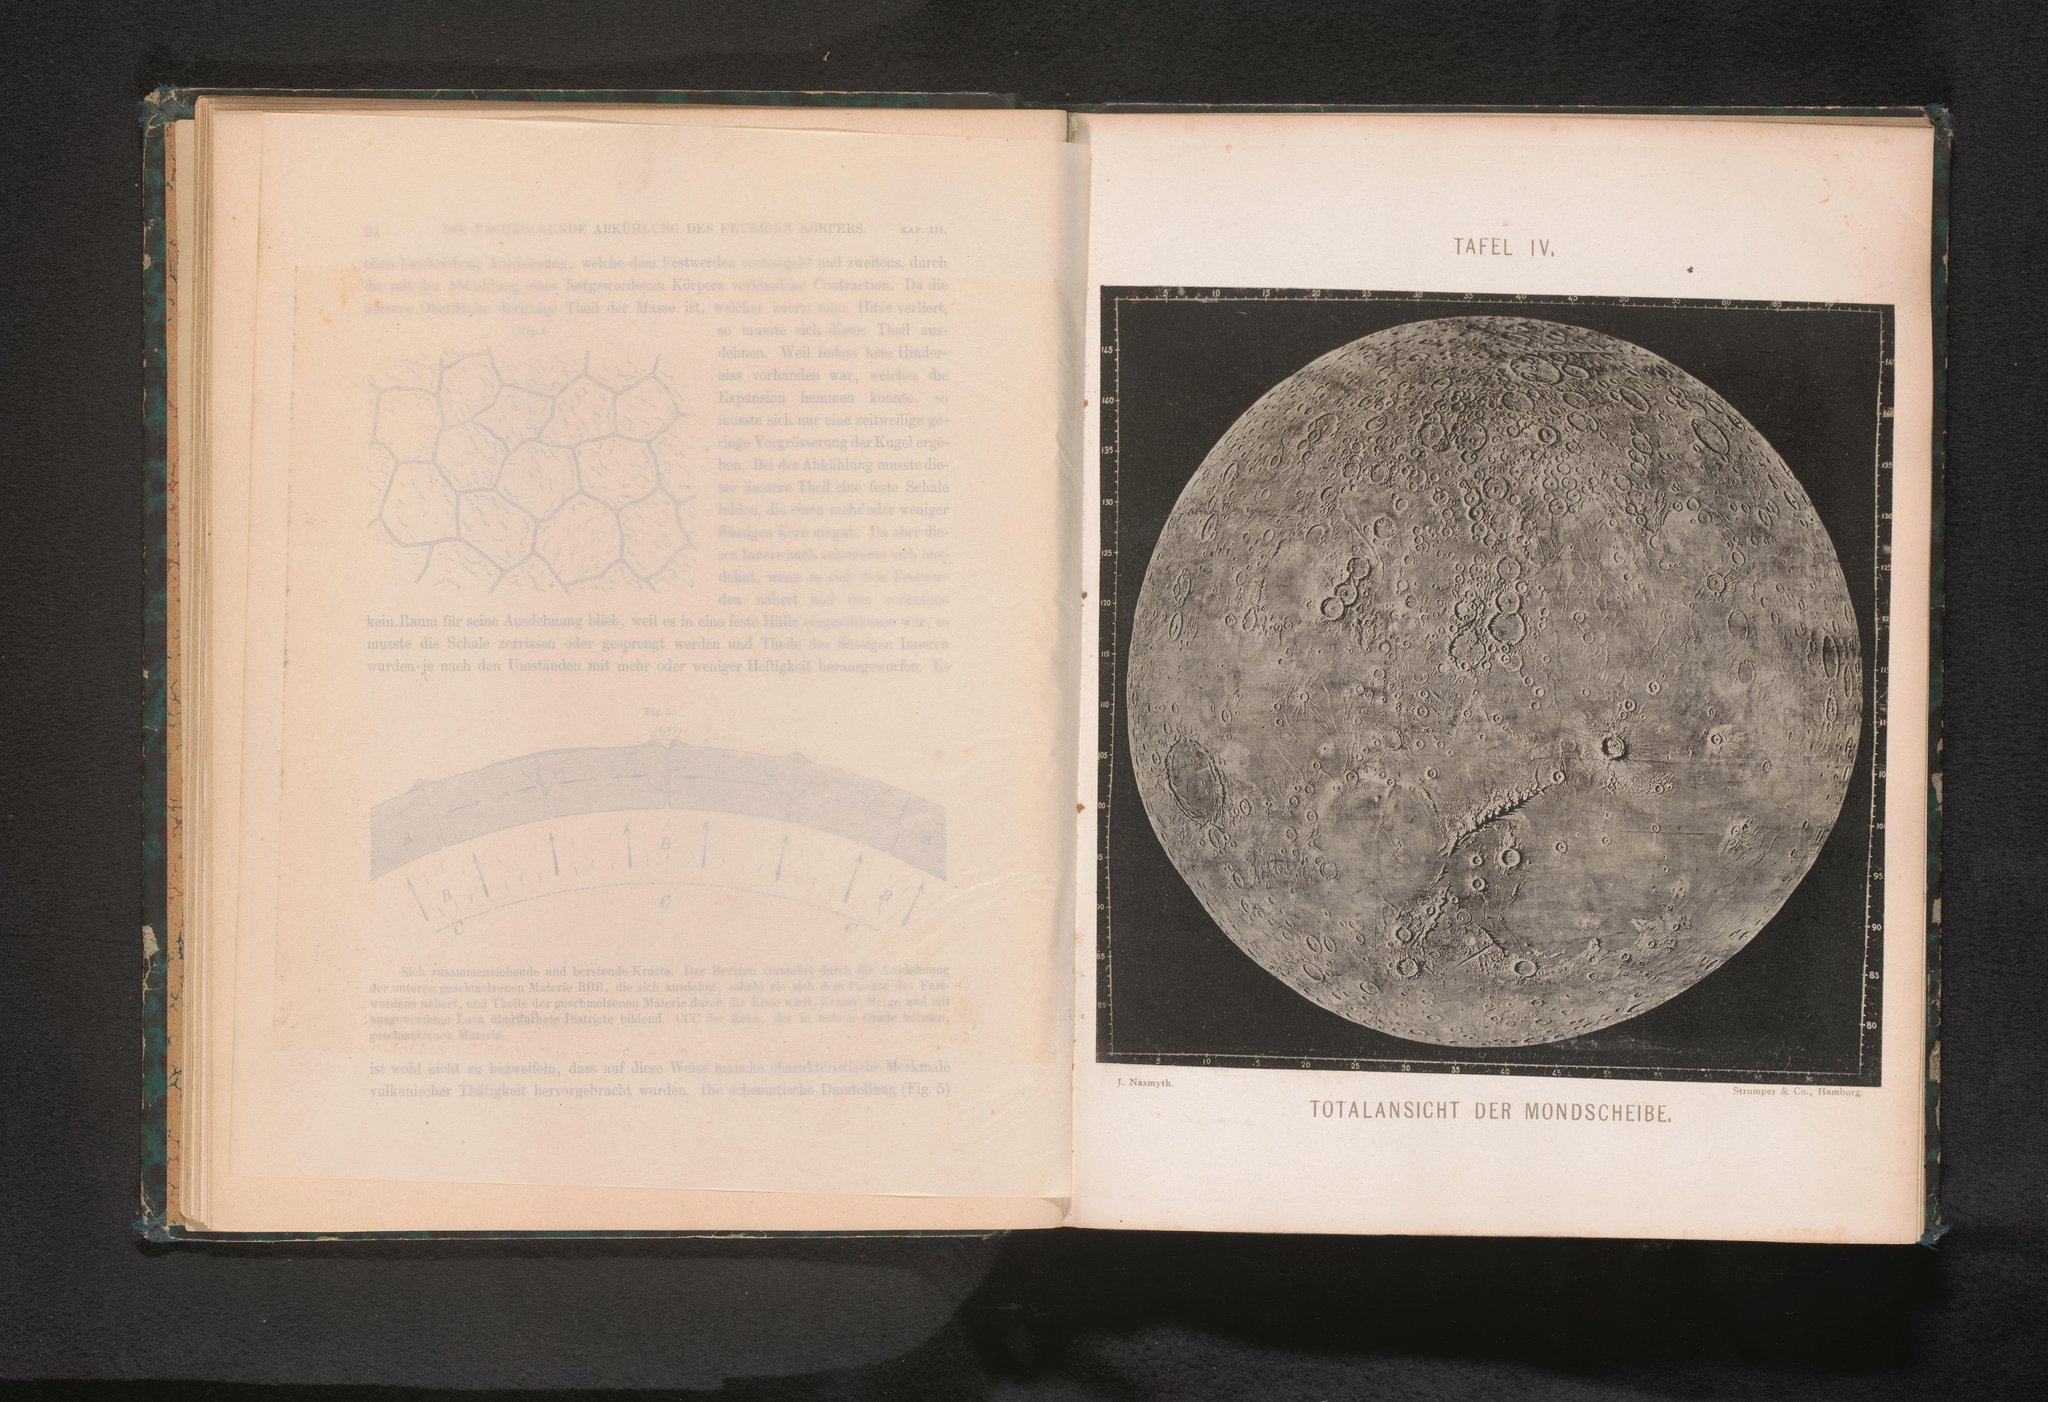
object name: page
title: Fotografische kaart van de maan met schaalverdeling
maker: james nasmyth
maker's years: 1808-1890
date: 1863-1873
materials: paper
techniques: photograph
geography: hamburg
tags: surface of the moon, moon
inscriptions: number: ‘Tafel IV.’